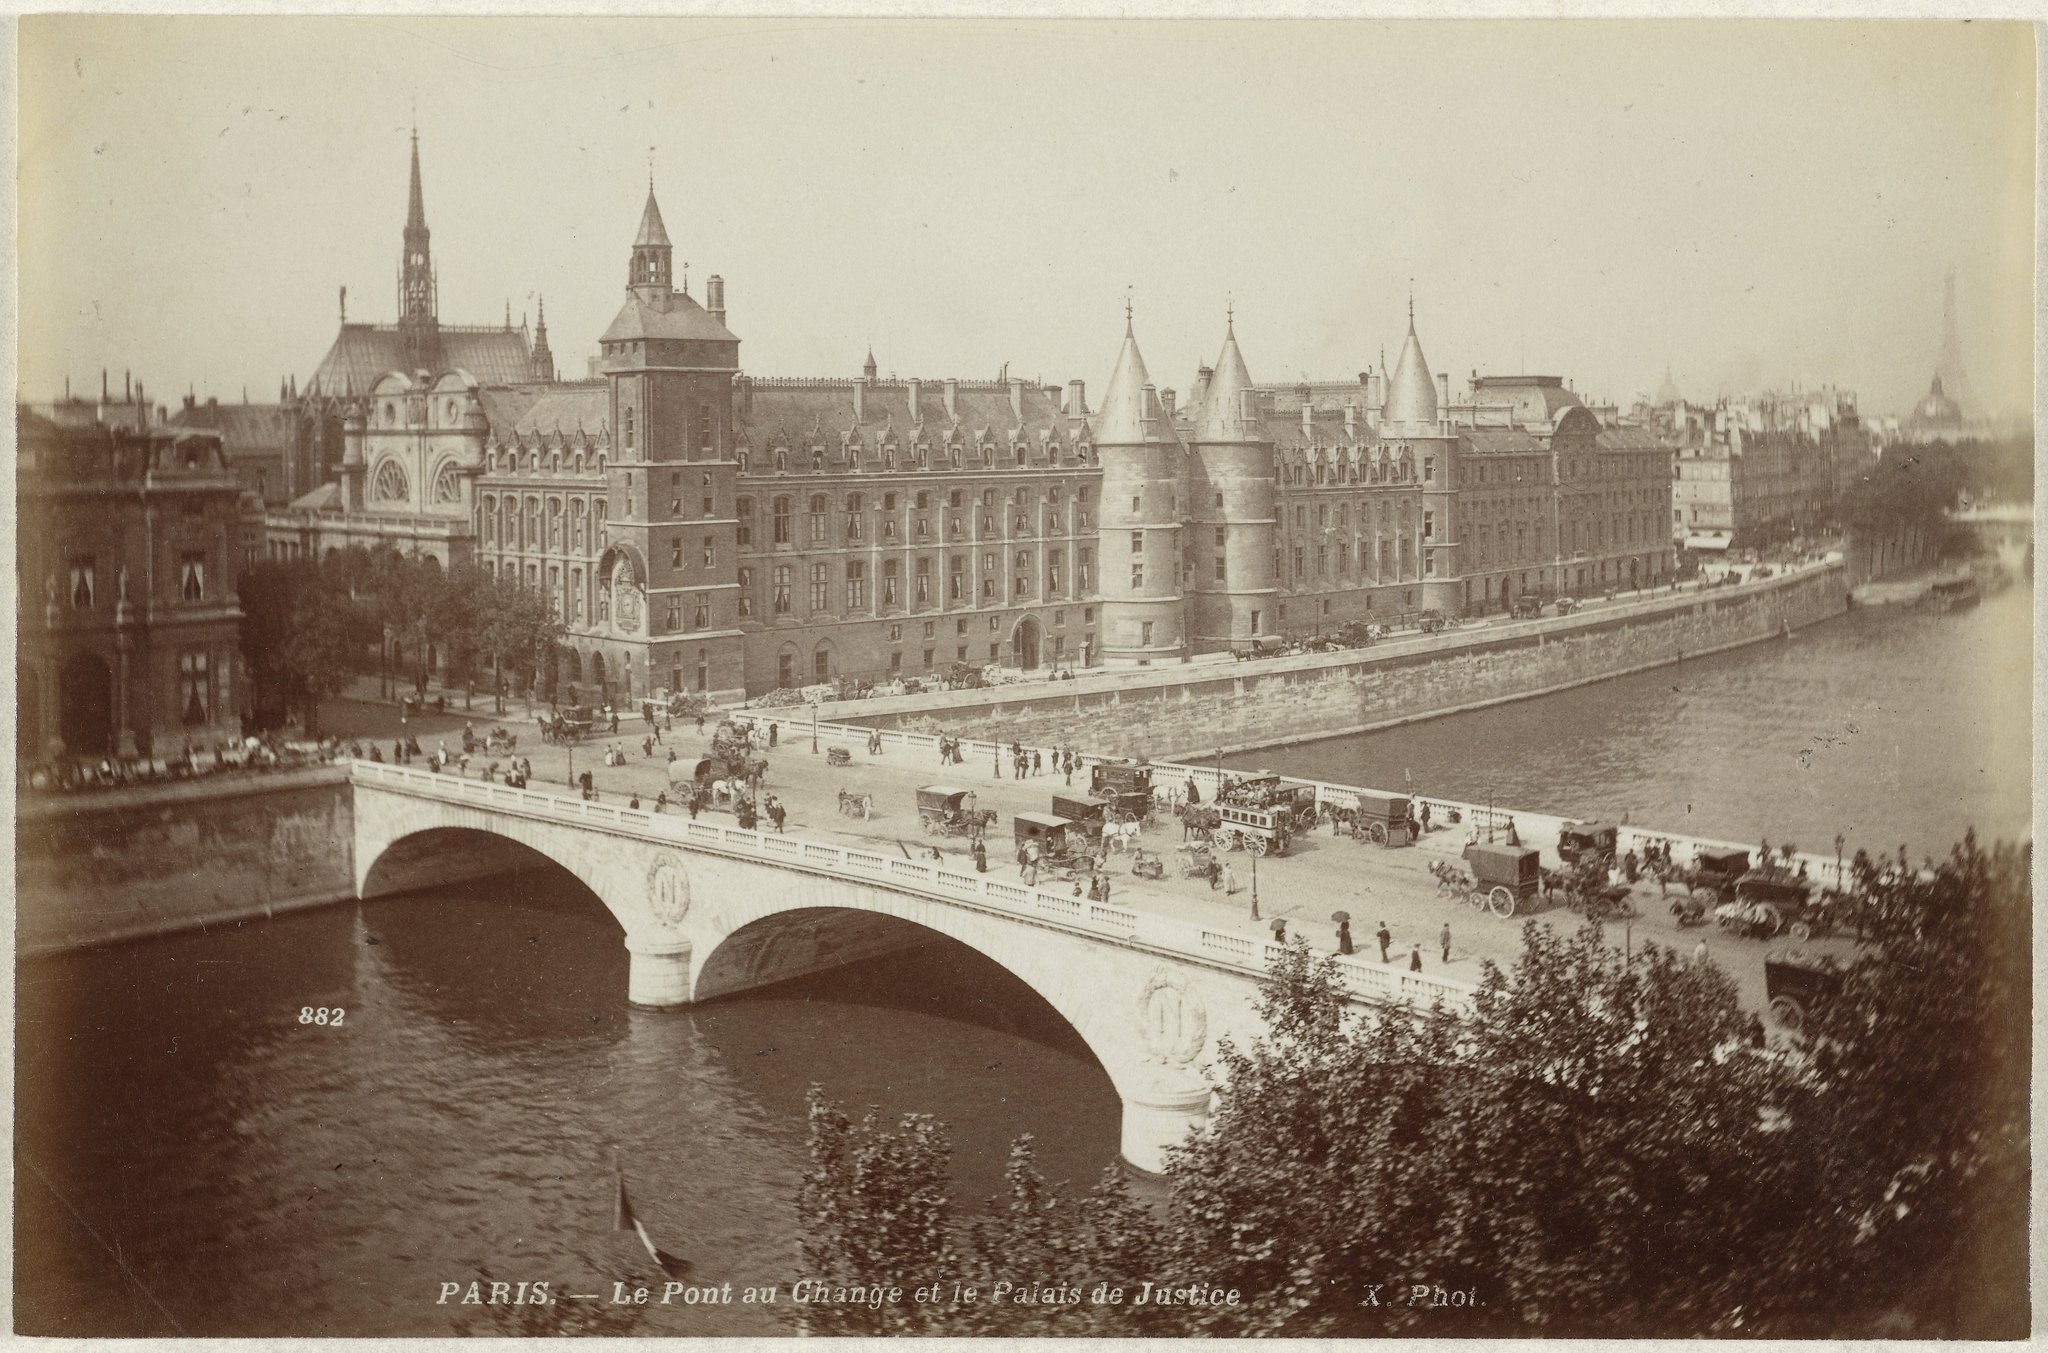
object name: photograph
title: Paris. - Le Pont au Change et le Palais de Justice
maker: jules hautecoeur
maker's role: publisher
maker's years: 1849-1935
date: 1889-1900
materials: paper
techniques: albumen print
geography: paris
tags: court building, river, bridge in city across river, canal, etc., paris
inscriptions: stamp: ‘Jules Hautecoeur/ Paris/ 172 Rue Rivoli’, inscription: ‘882/ Paris. - Le Pont au Change et le Palais de Justice. X Phot.’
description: Tussen 1887 en ca. 1900 werkten Neurdein frères onder andere onder de naam 'X phot.'.